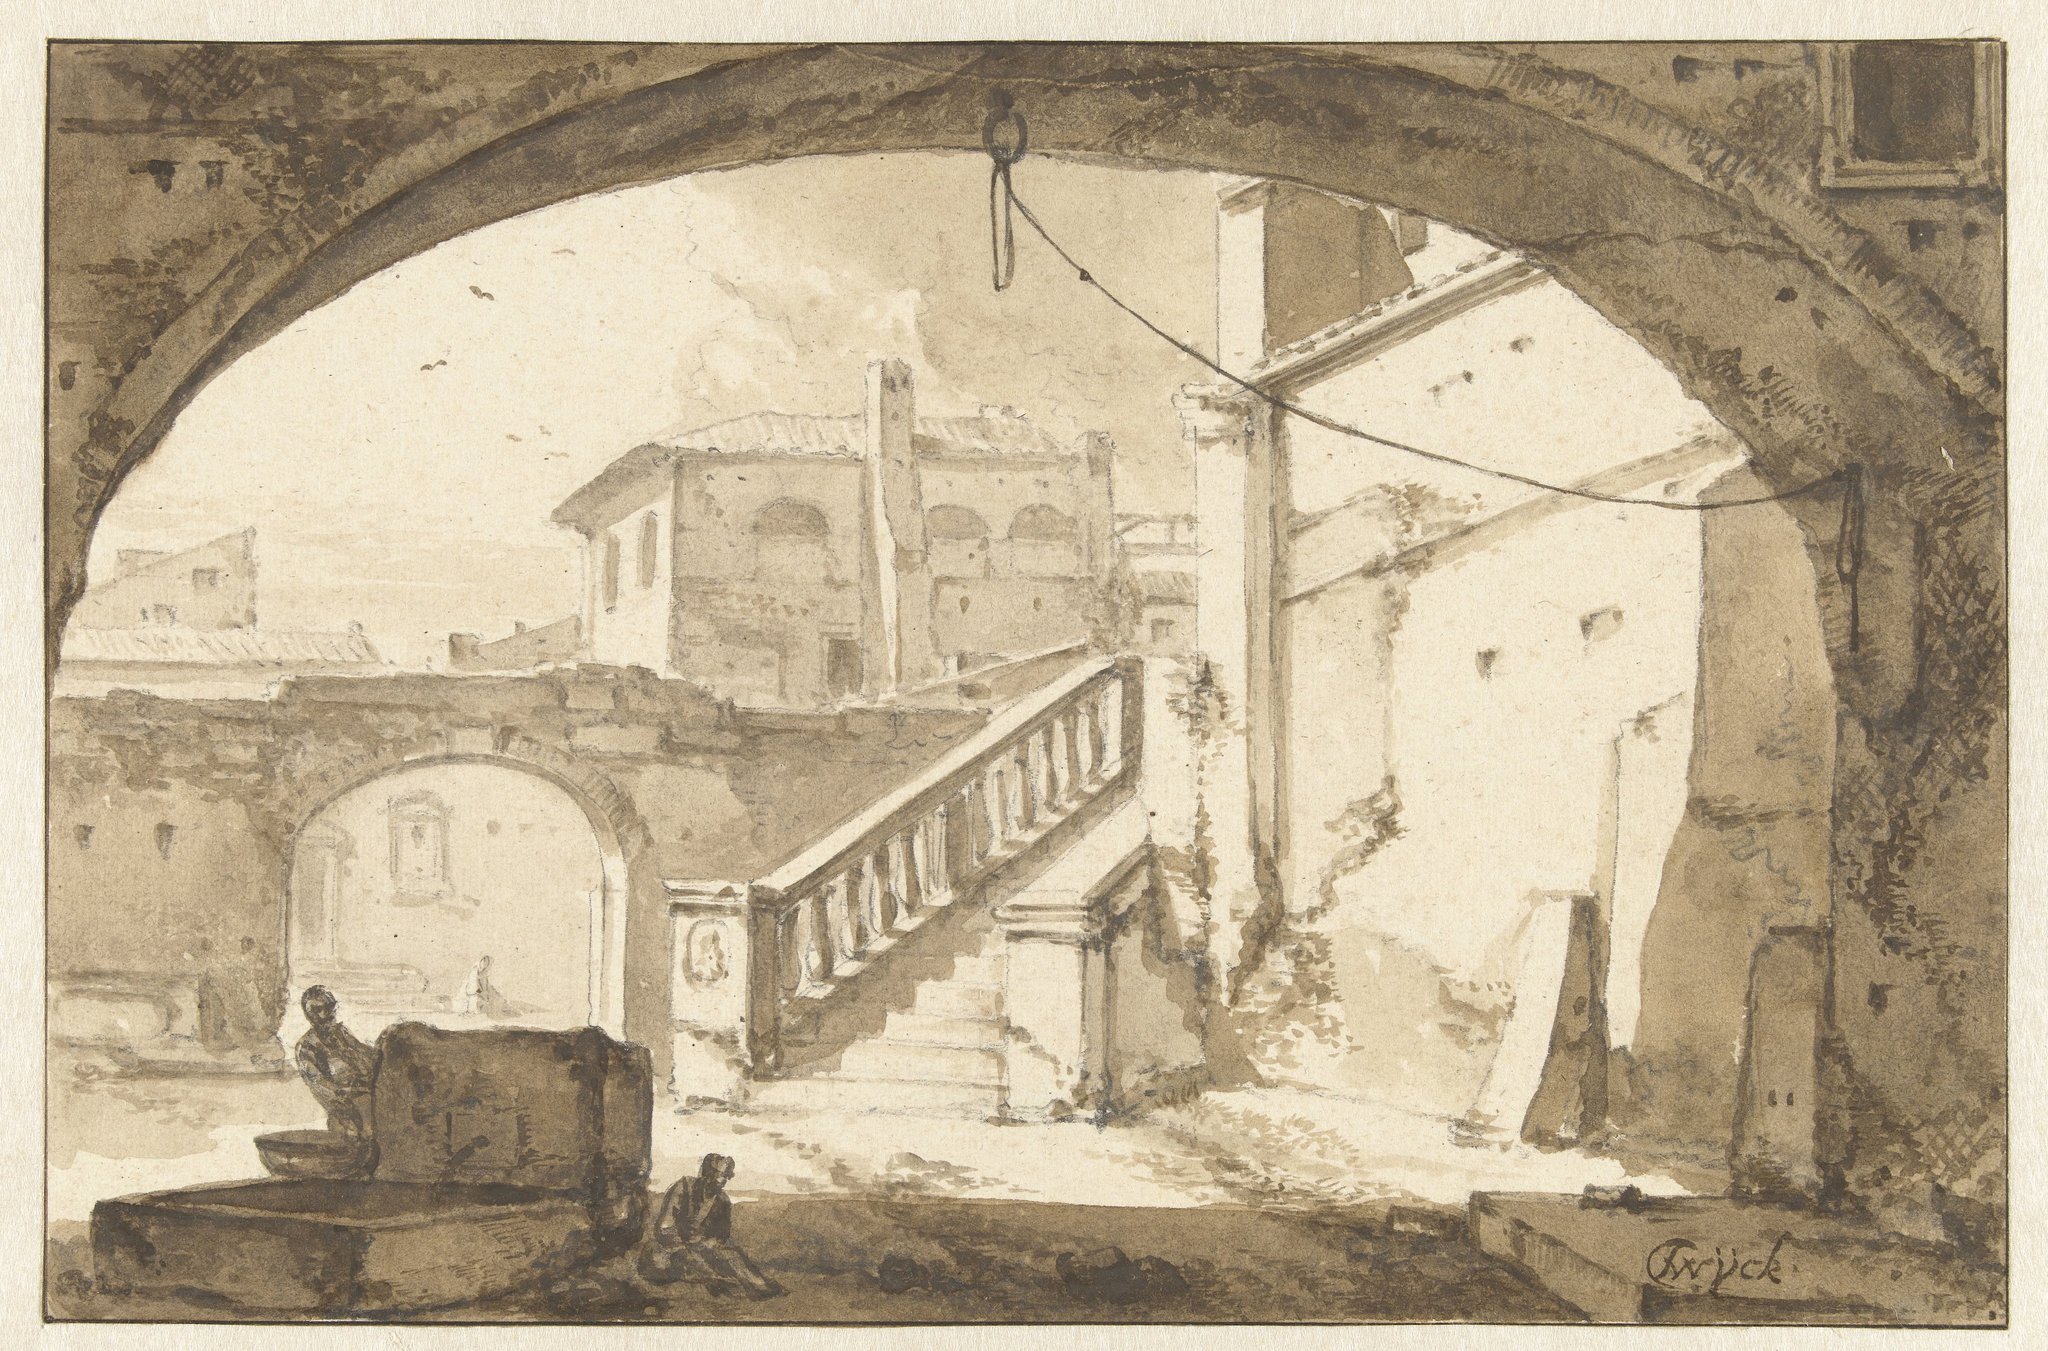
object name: drawing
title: Gezicht door een boog op een Italiaanse binnenplaats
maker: thomas wijck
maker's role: draughtsman, painter, print maker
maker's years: 1616-1677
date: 1626-1677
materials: graphite, paper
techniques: brush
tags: courtyard, italy